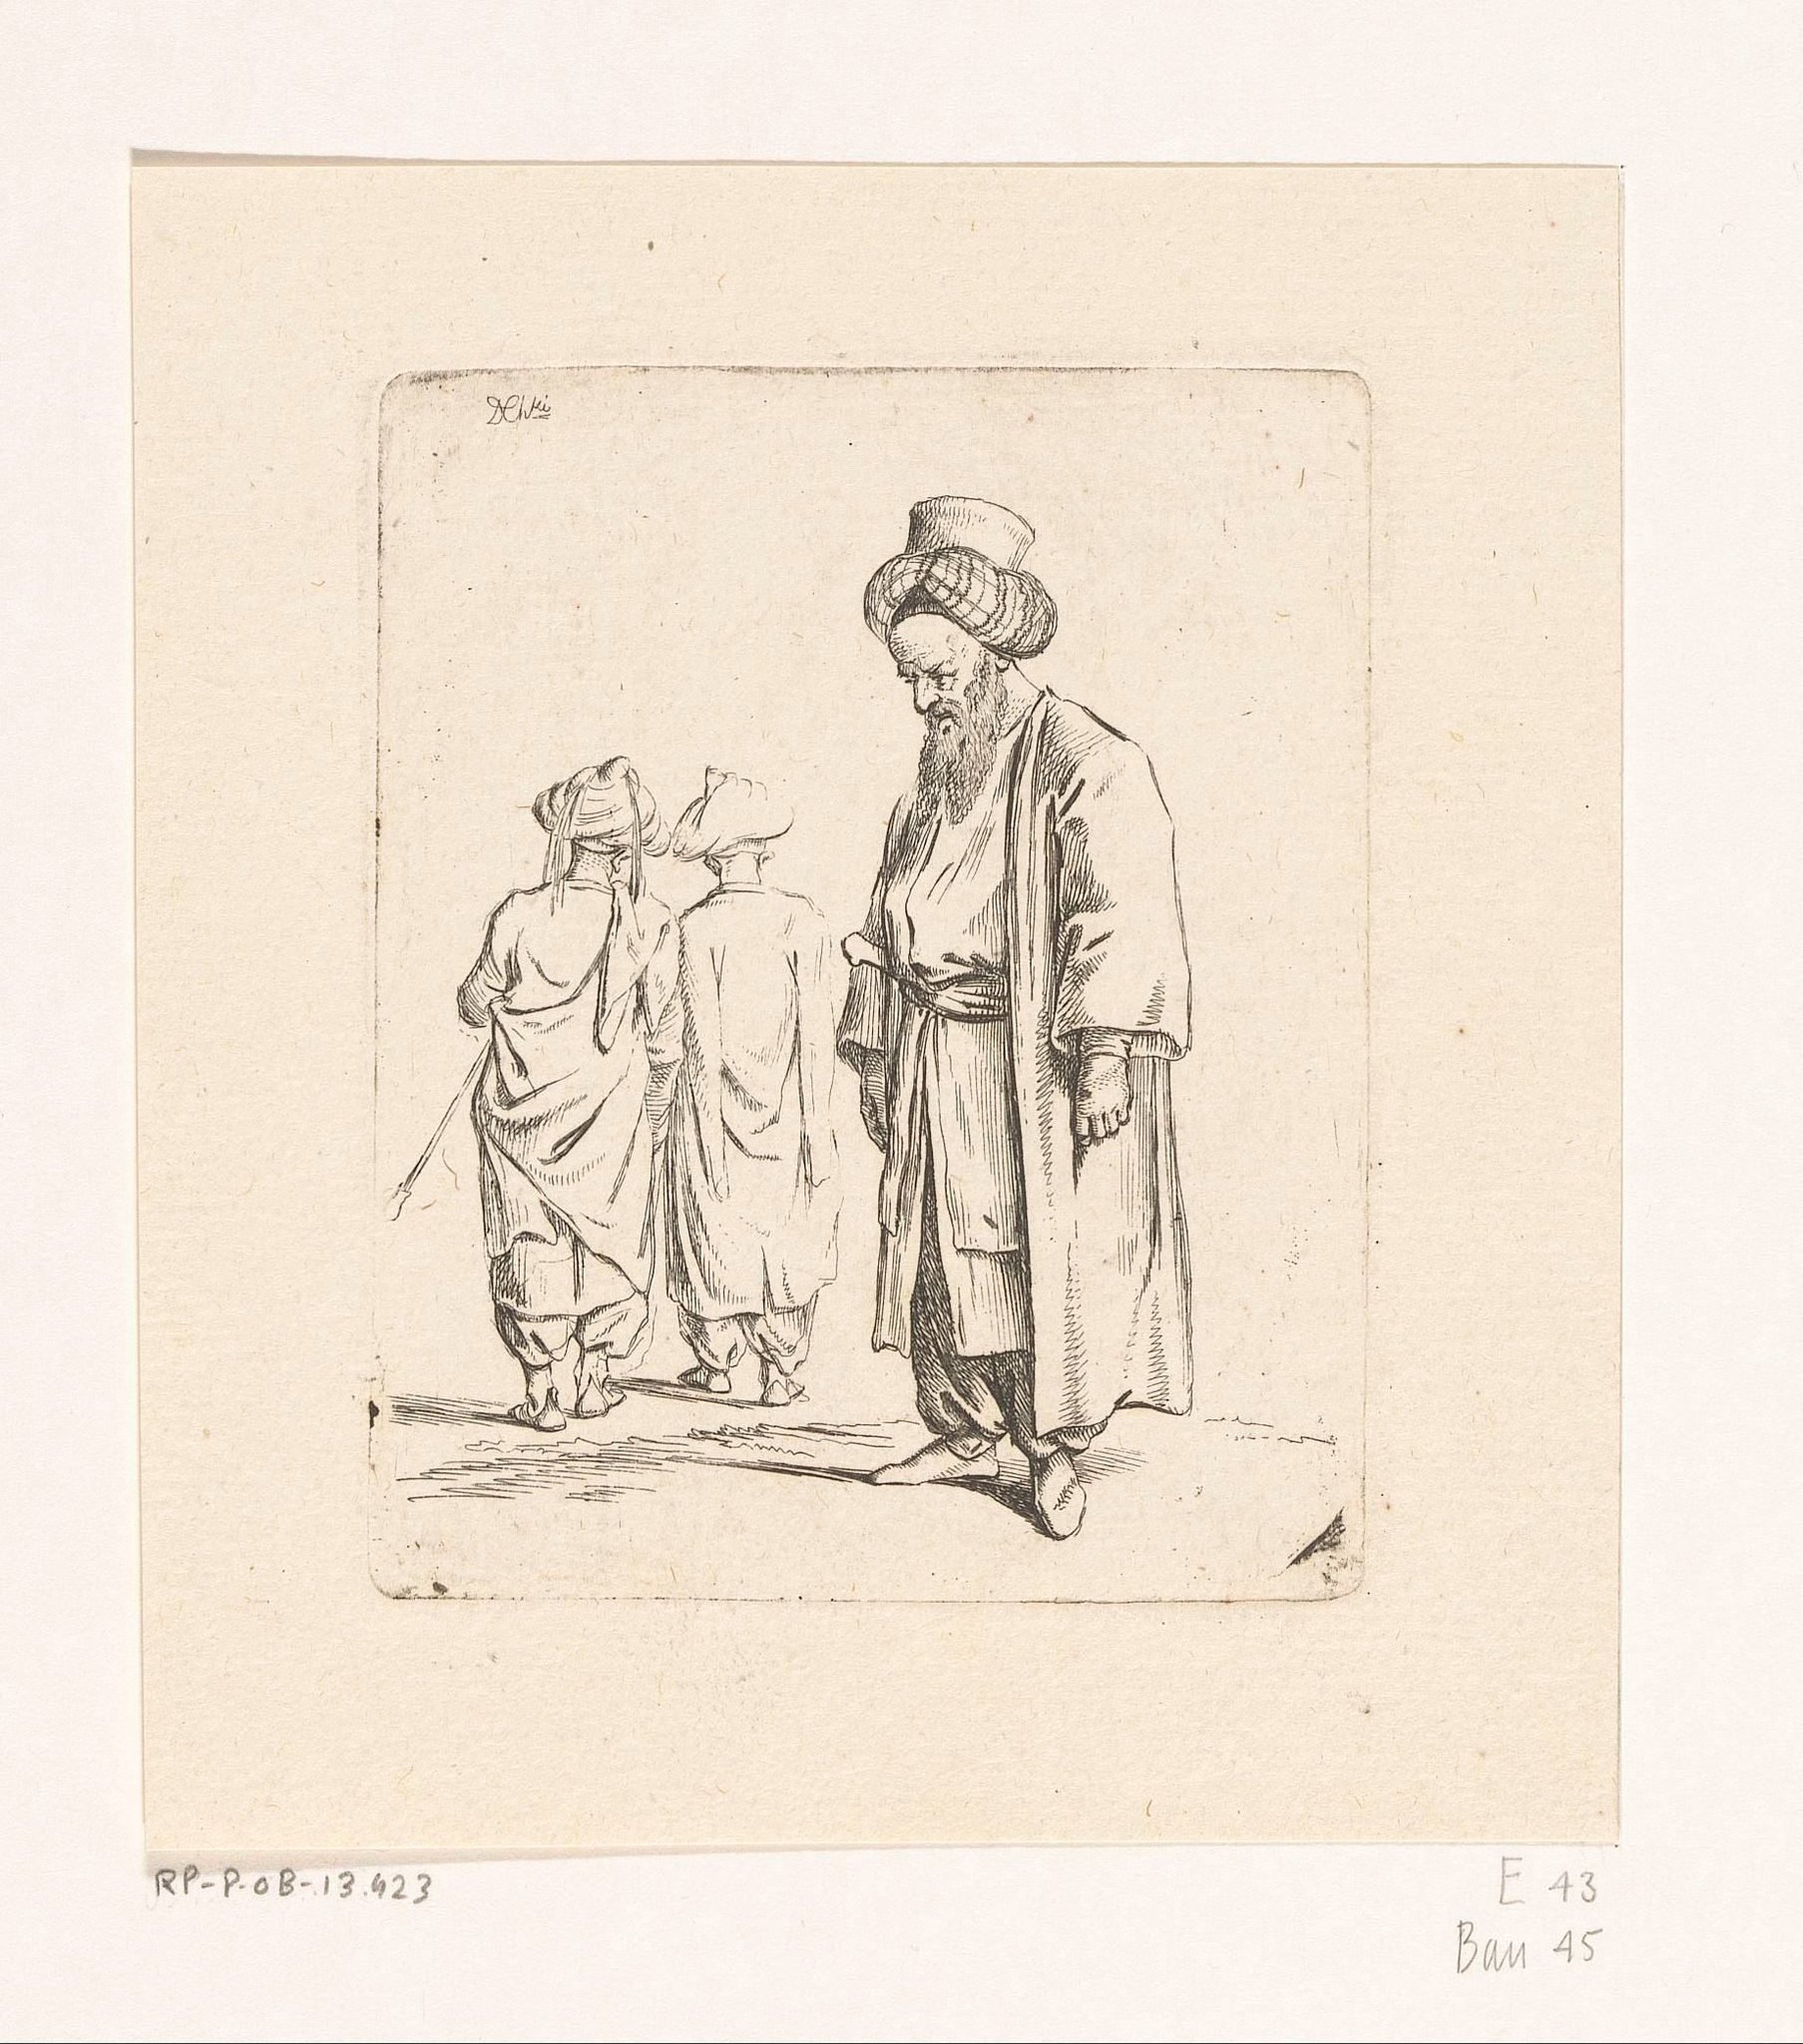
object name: print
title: Drie Turken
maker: daniel nikolaus chodowiecki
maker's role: draughtsman, print maker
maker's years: 1726-1801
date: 1764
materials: paper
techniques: etching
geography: berlin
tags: asiatic races and peoples: turks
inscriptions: collector's mark: Lugt 2228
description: Deze Turkse mannen waren waarschijnlijk afkomstig uit het gevolg van Ahmed Resmi Efendi die als ambassadeur van het Ottomaanse Rijk in Berlijn verbleef tussen 1763-1764.